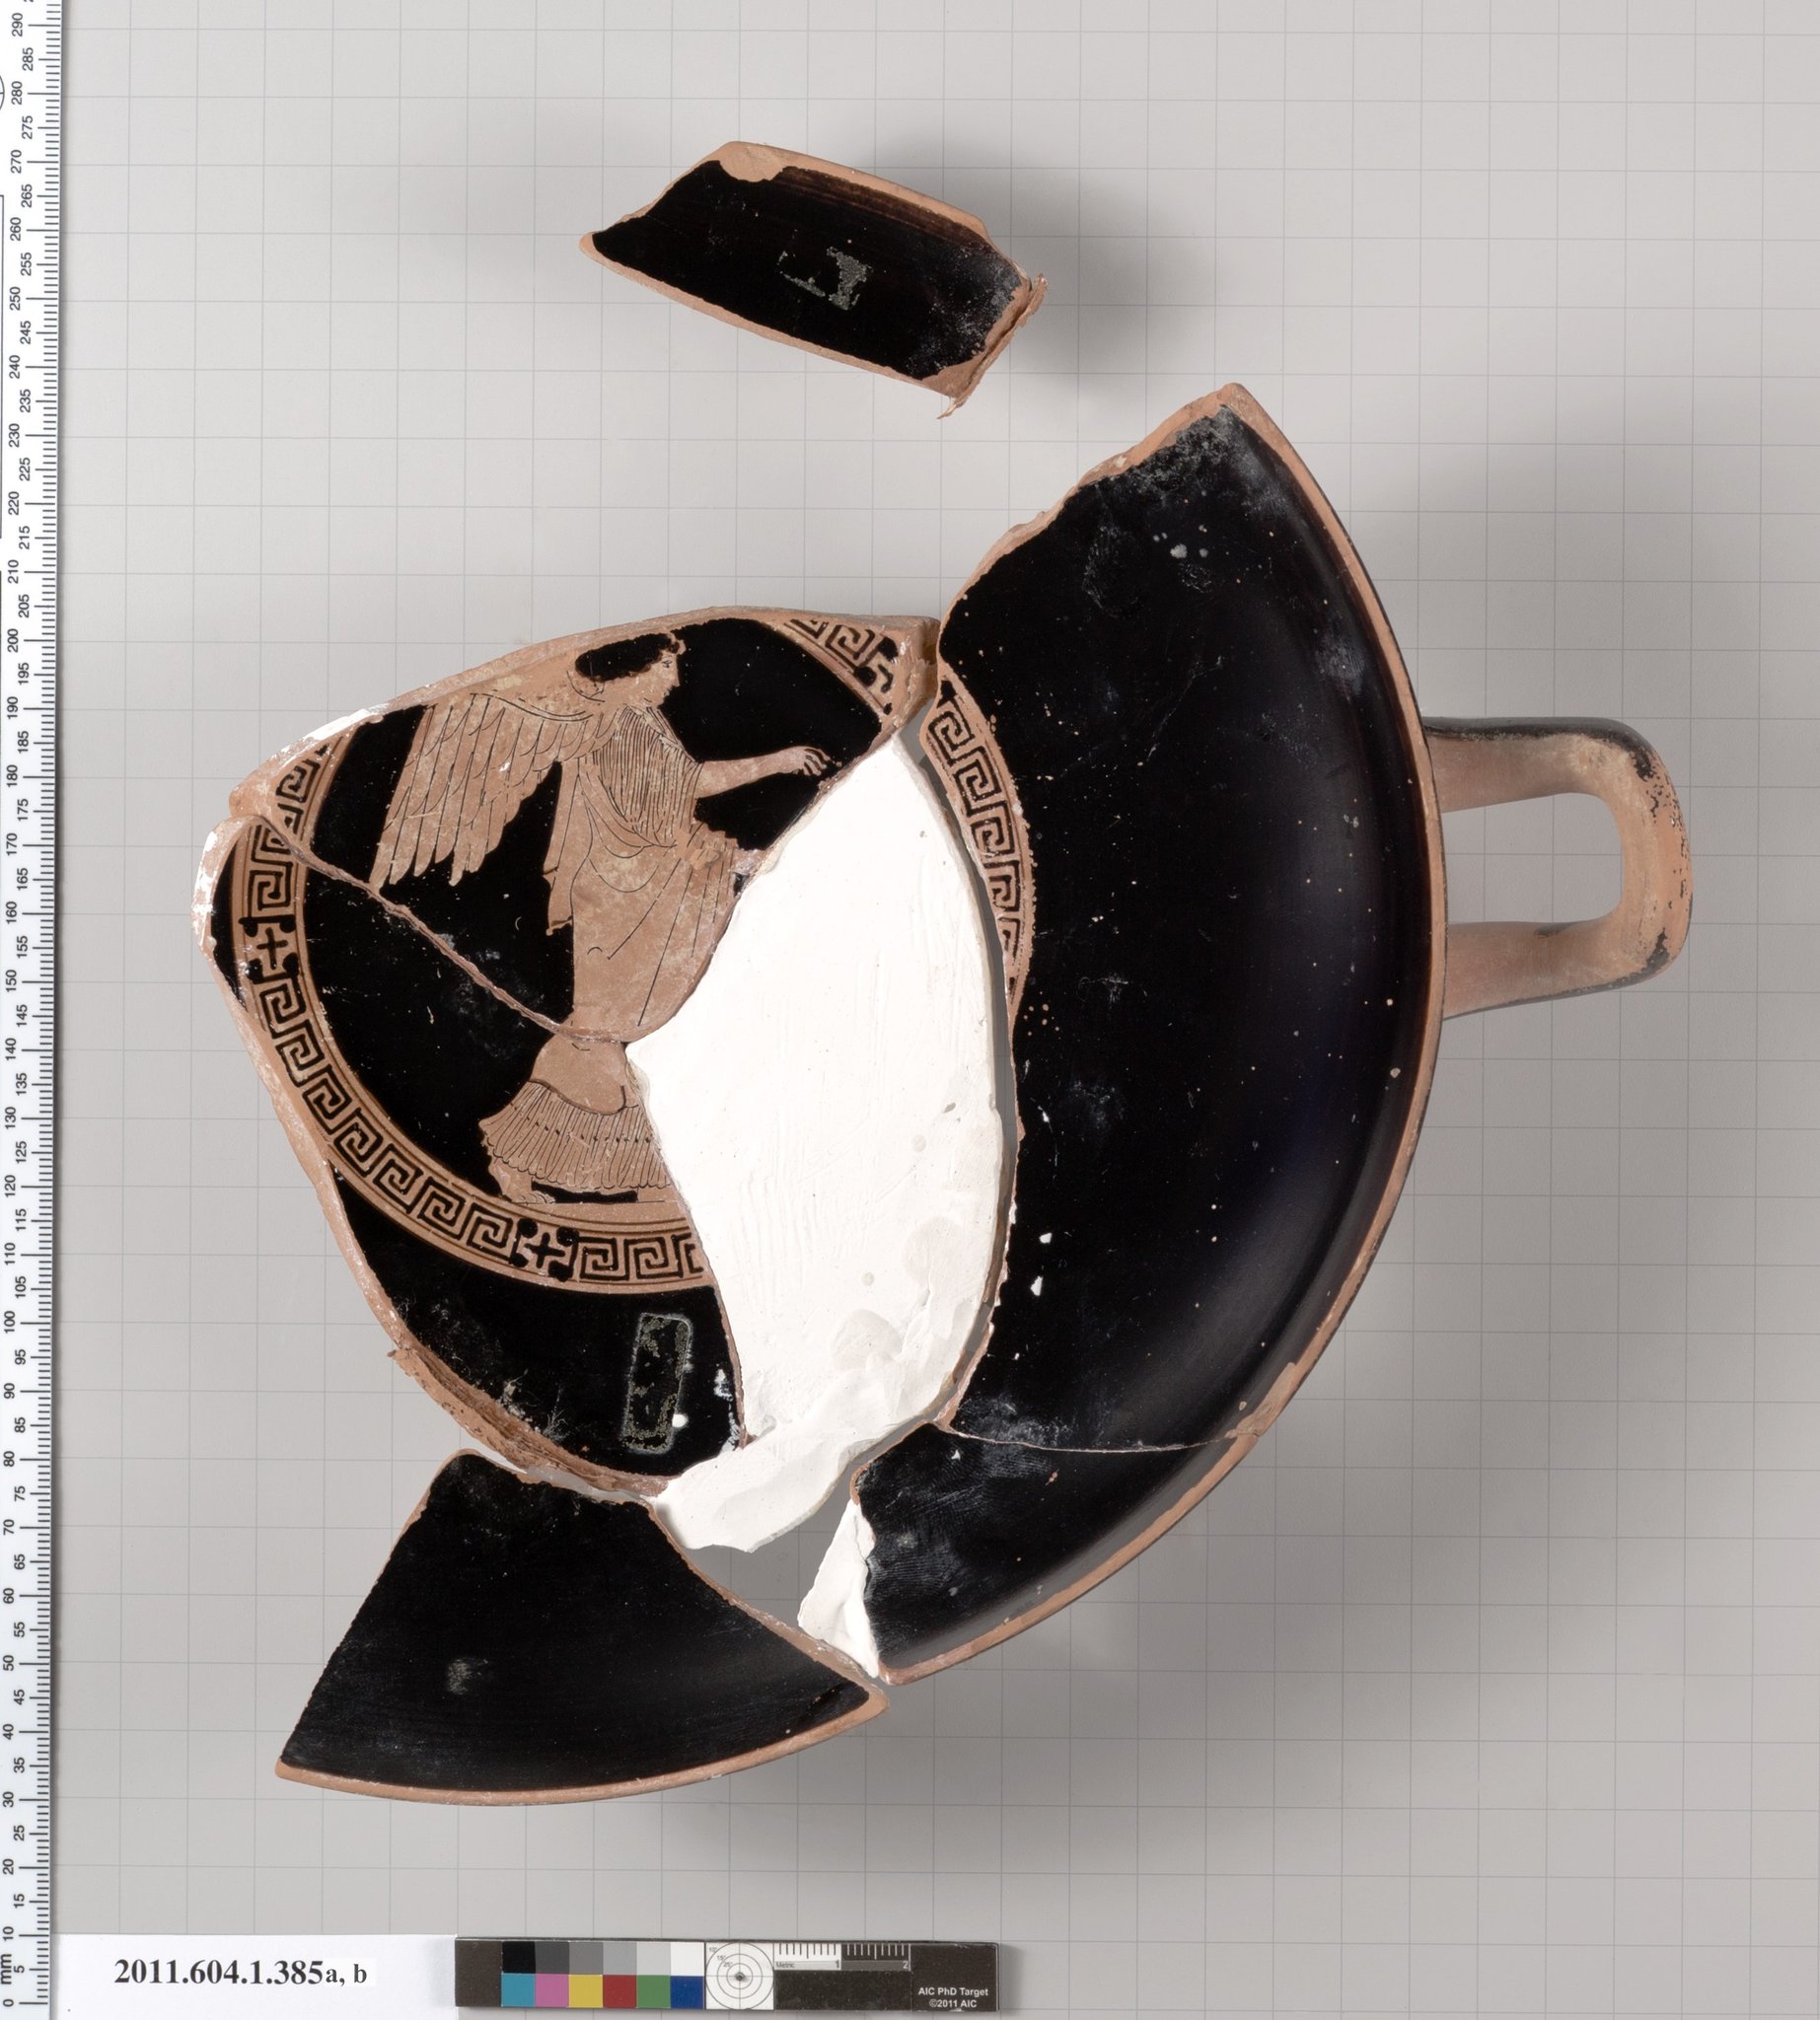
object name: kylix fragment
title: Terracotta fragments of a kylix (drinking cup)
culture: greek, attic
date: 475-451 BCE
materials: terracotta